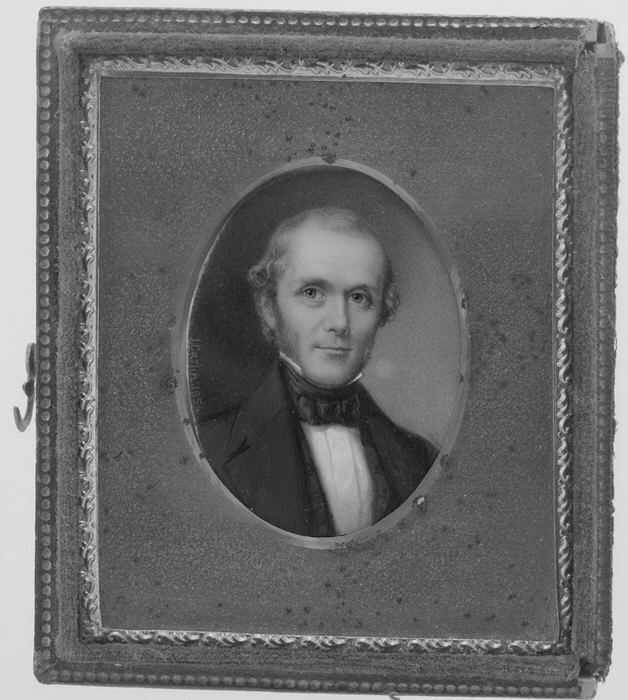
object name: painting, miniature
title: Portrait of a Gentleman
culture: american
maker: john carlin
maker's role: artist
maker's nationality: american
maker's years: 1813-1891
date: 1854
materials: ivory, watercolor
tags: men,portraits